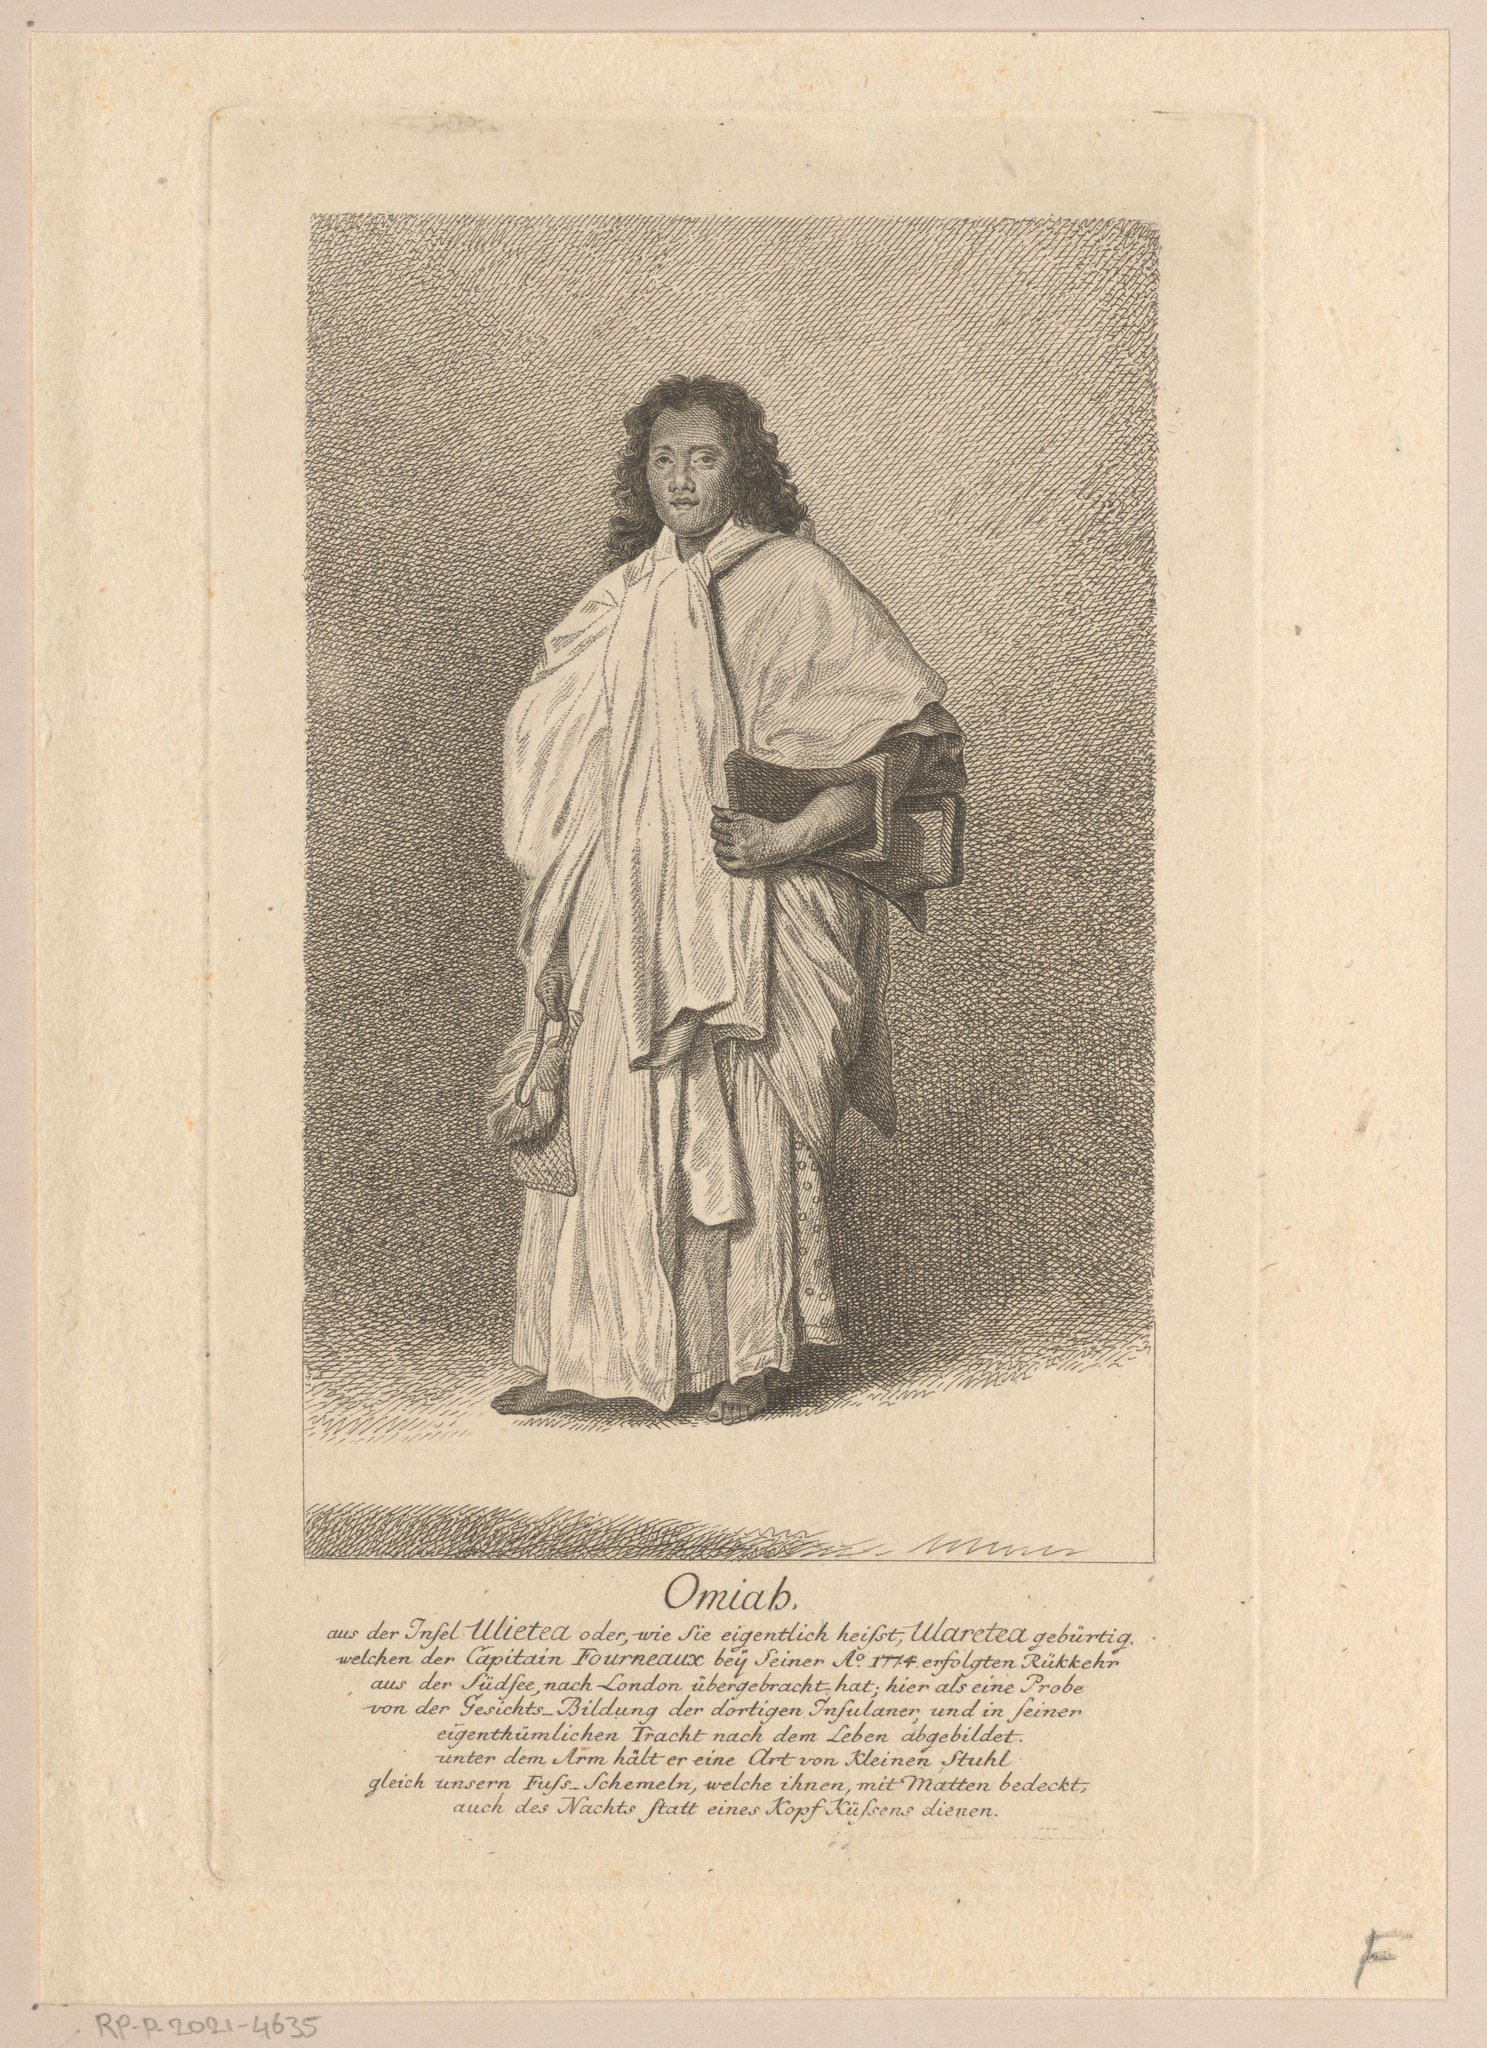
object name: print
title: Portret van Omai, bewoner van Raiatea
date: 1774-1815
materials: paper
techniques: engraving, etching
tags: historical persons